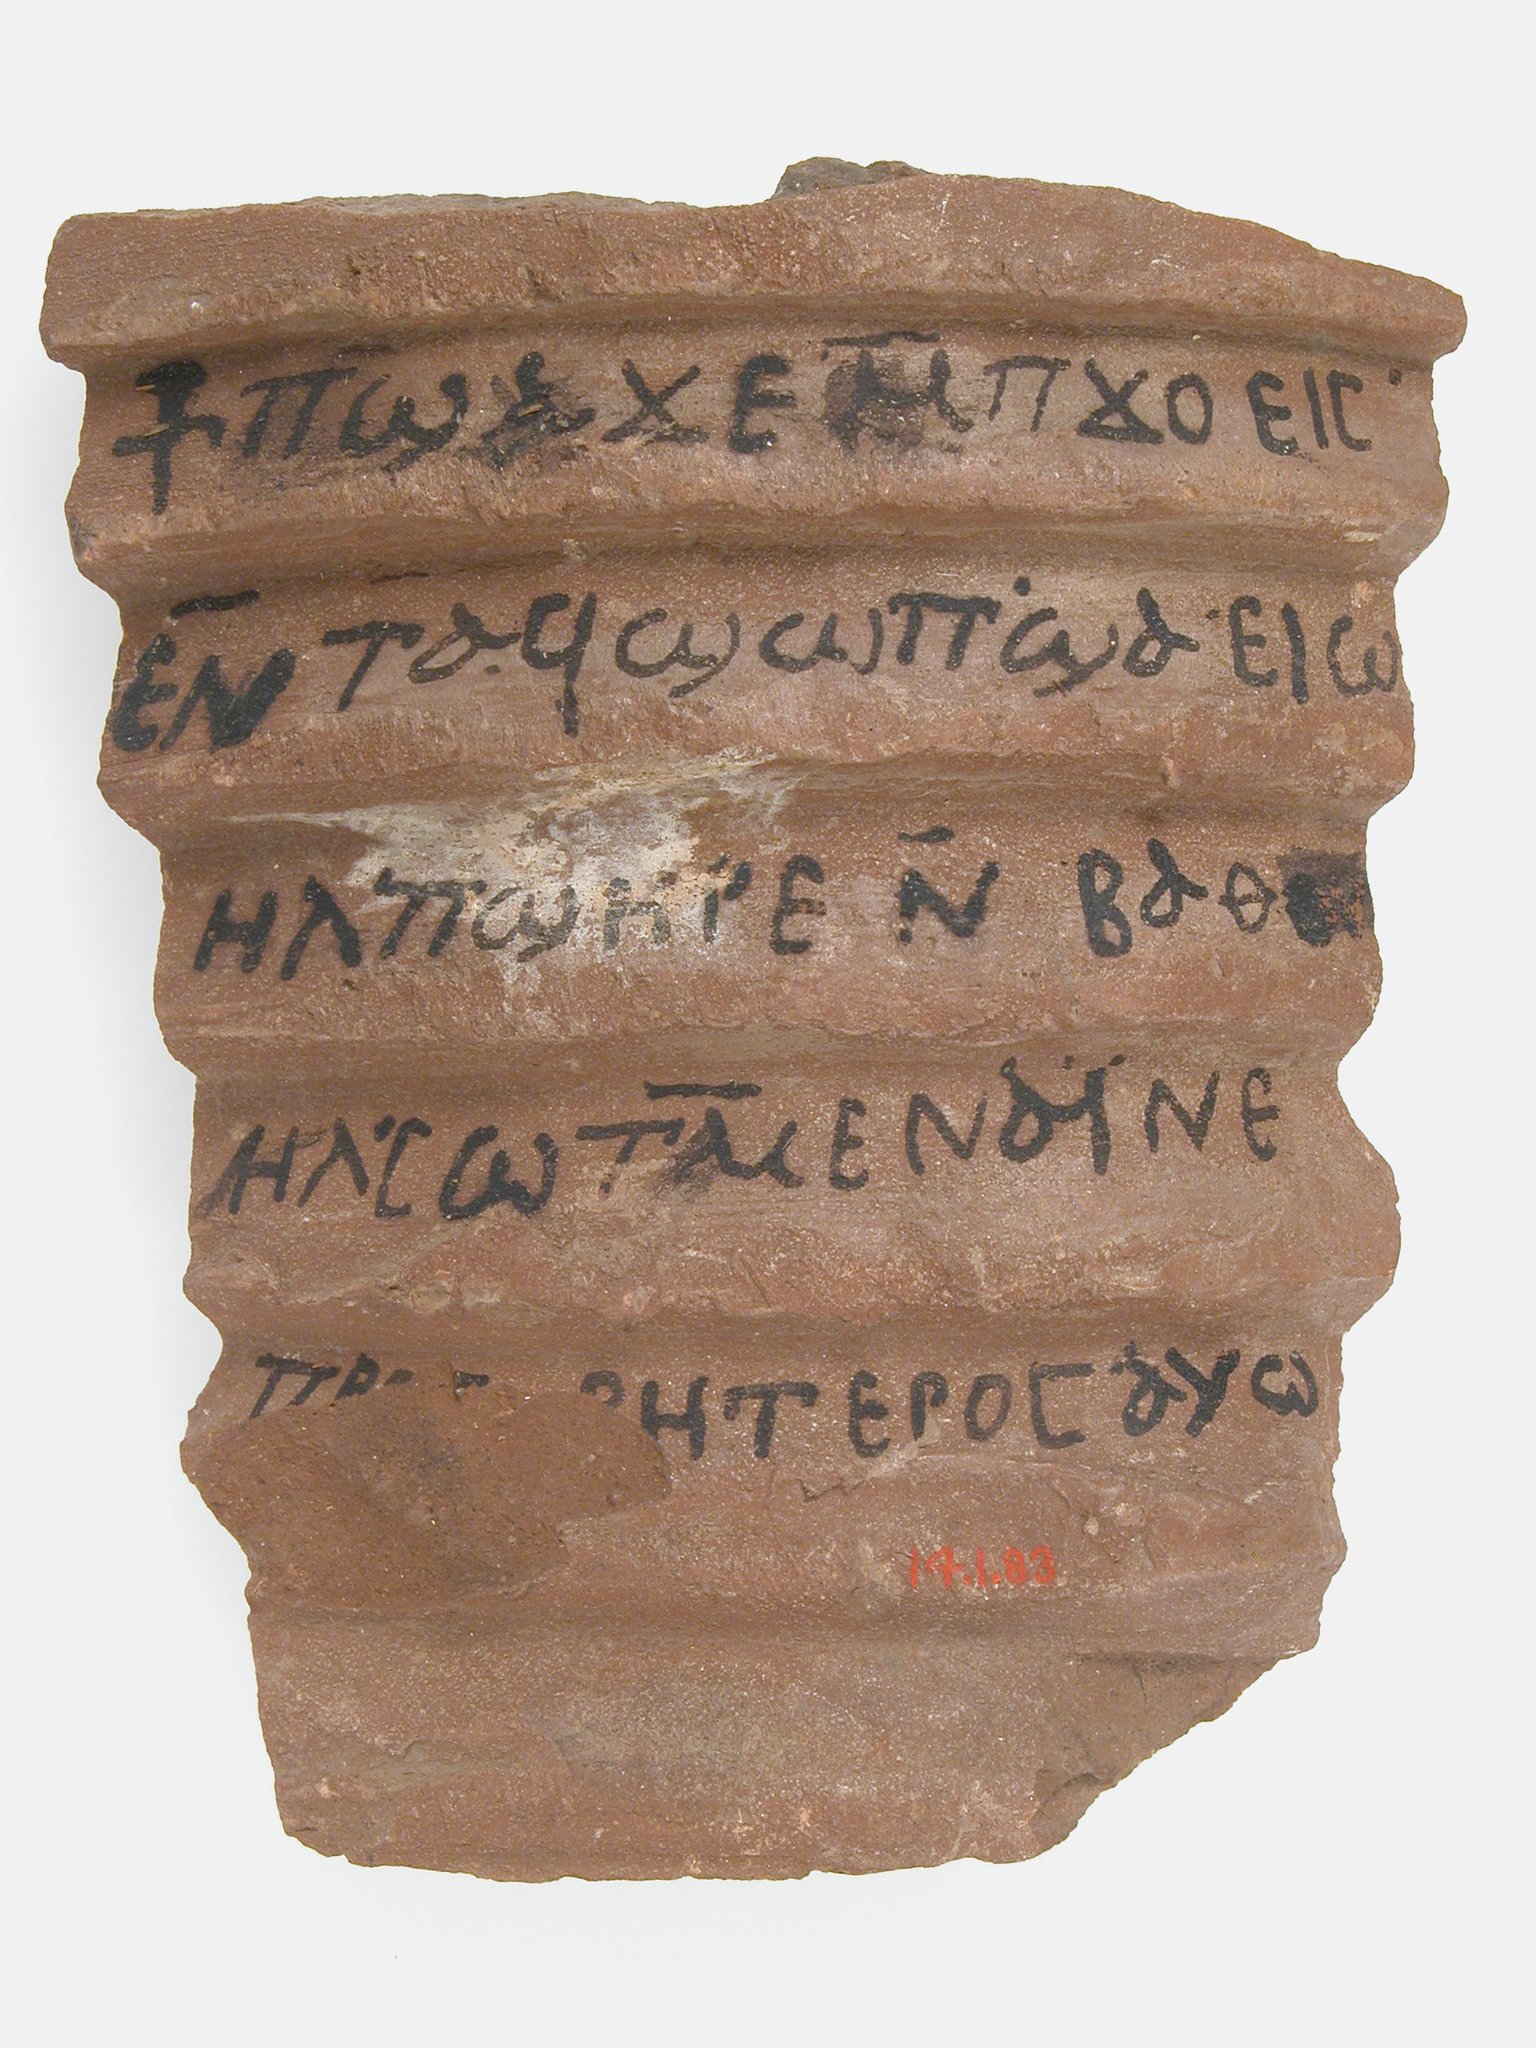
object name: ostrakon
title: Ostrakon with Biblical Text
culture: coptic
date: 600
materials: ink, pottery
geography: egypt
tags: coptic